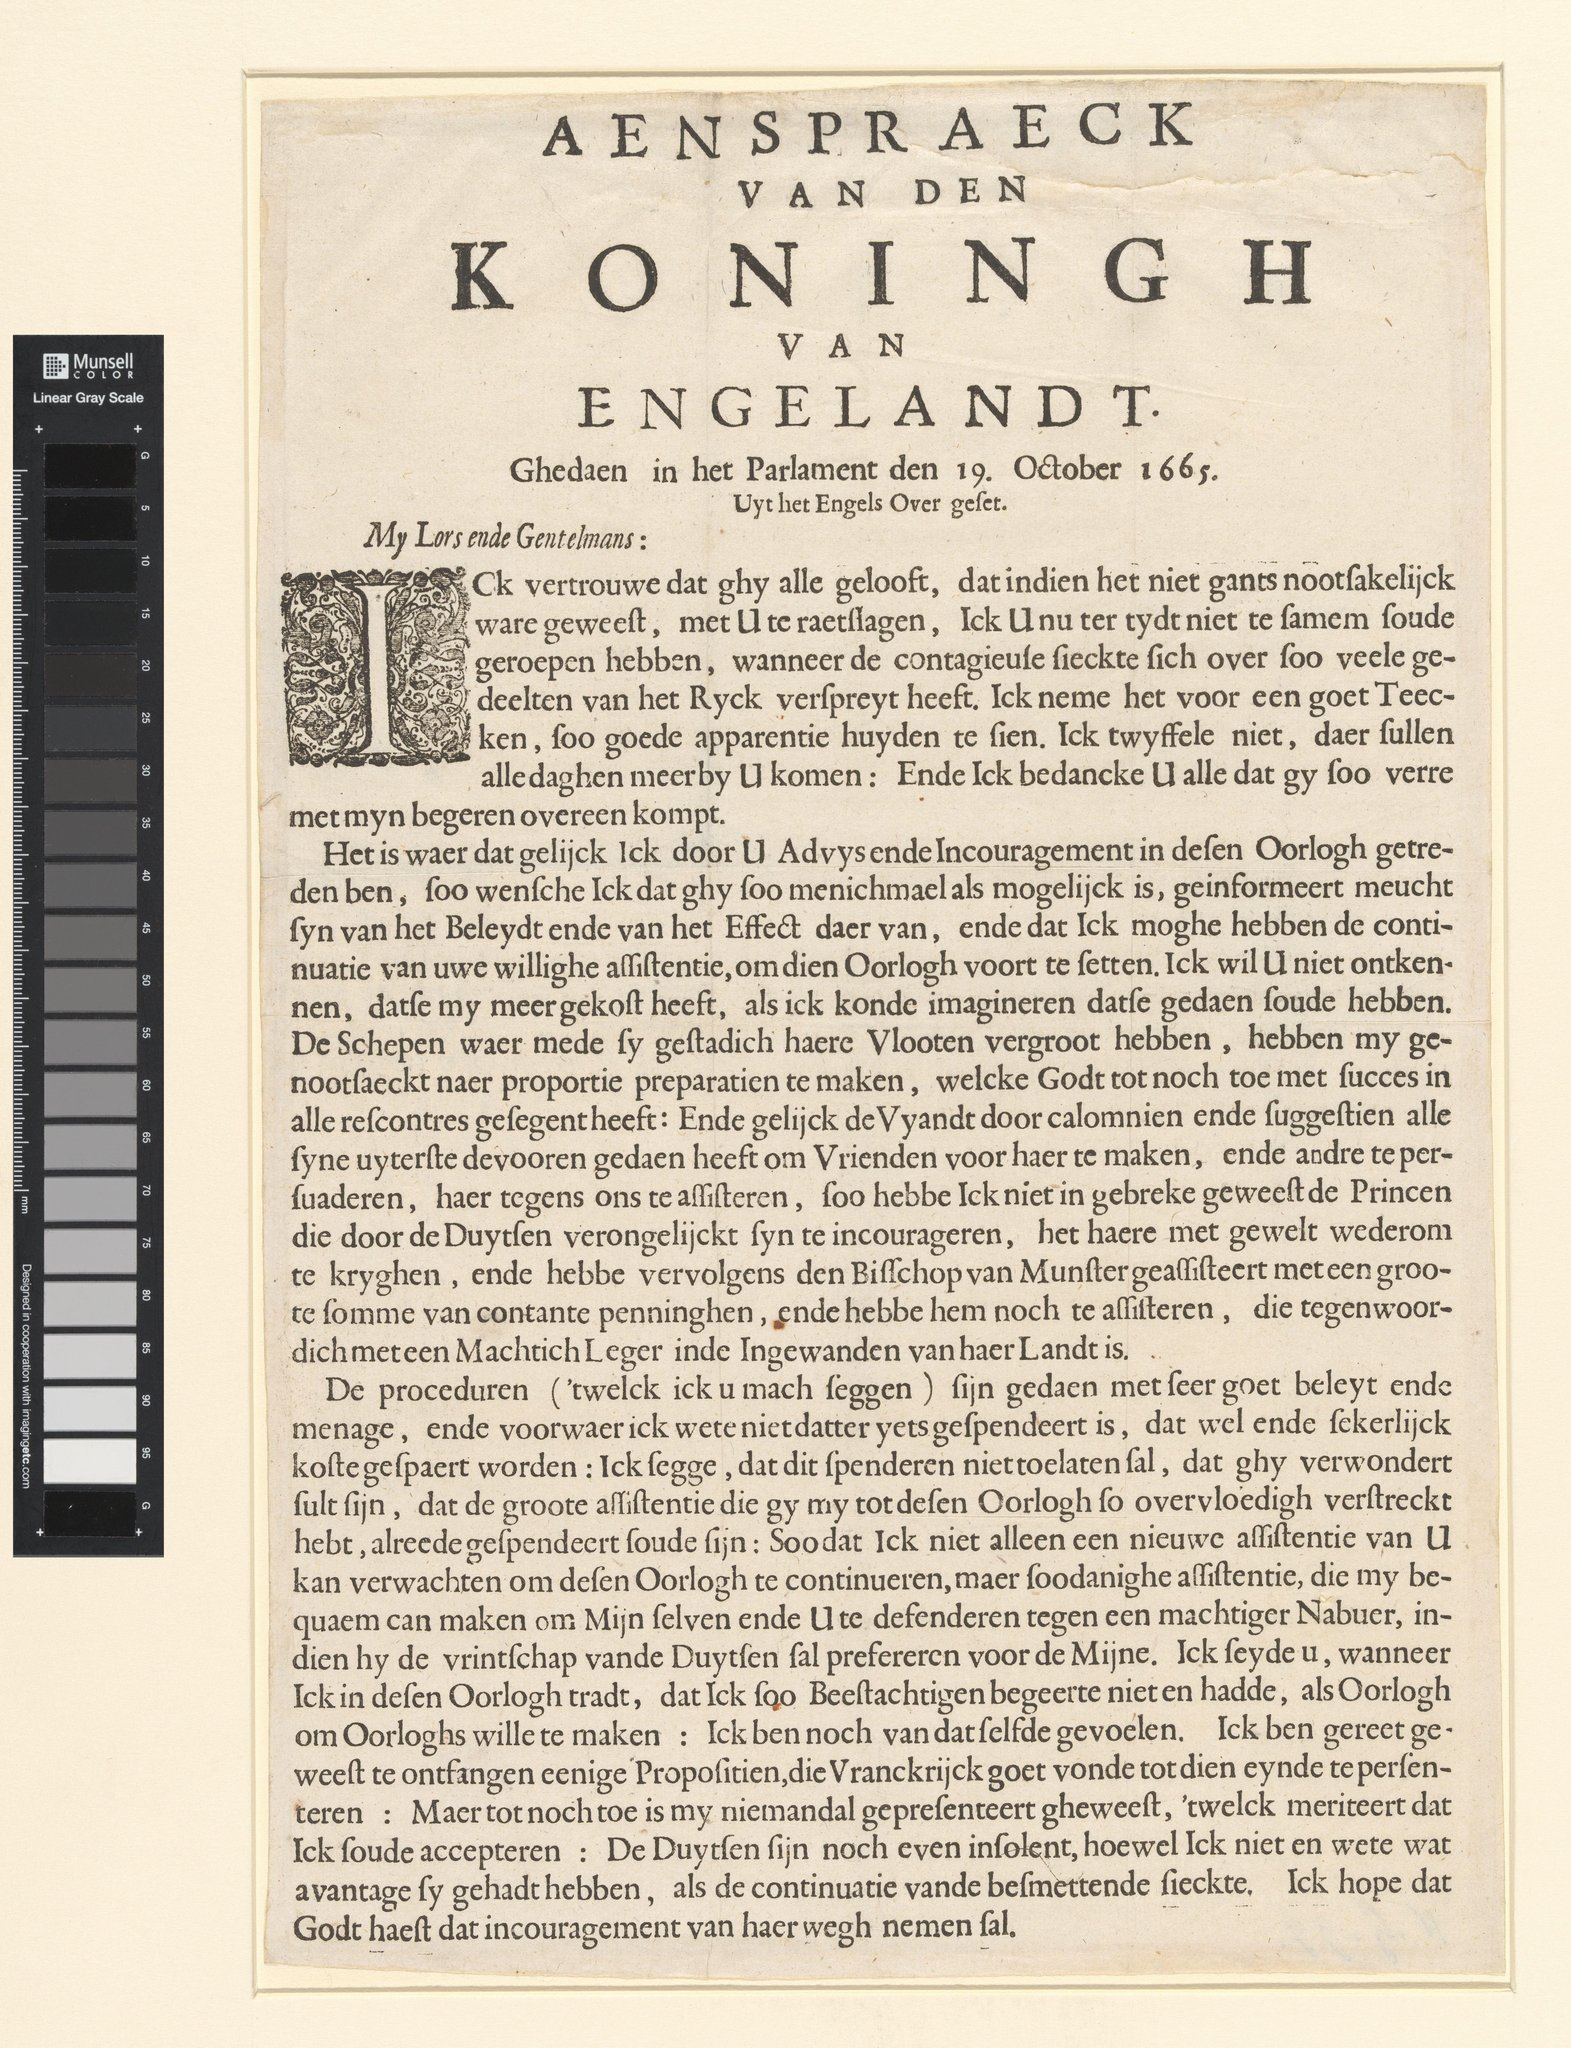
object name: pamphlet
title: Aenspraeck van den Koningh van Engelandt, ghedaen in het Parlament den 19. October 1665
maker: karel ii (koning van engeland)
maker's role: koning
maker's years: 1630-1685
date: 1665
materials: paper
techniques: printing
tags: london, karel ii (koning van engeland)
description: Eénzijdig bedrukt blad papier, met nederlandstalige tekst ("uyt het engels Over geset"), l.b. versierde I.